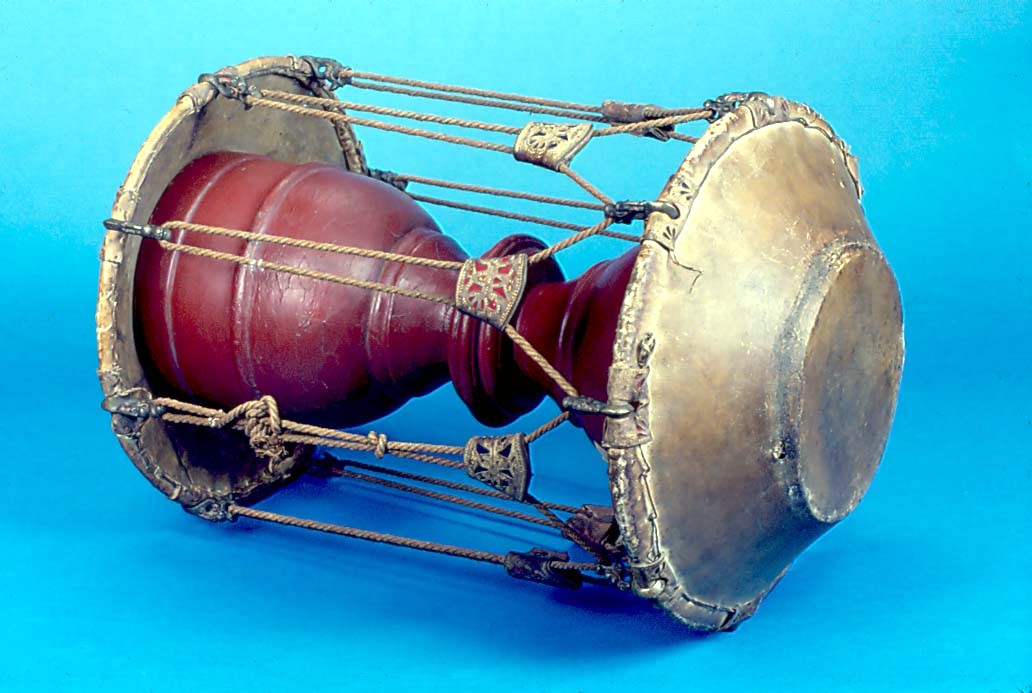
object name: changgo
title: Changgo (장구 )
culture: korean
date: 1801-1900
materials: metal, fiber, wood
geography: korea